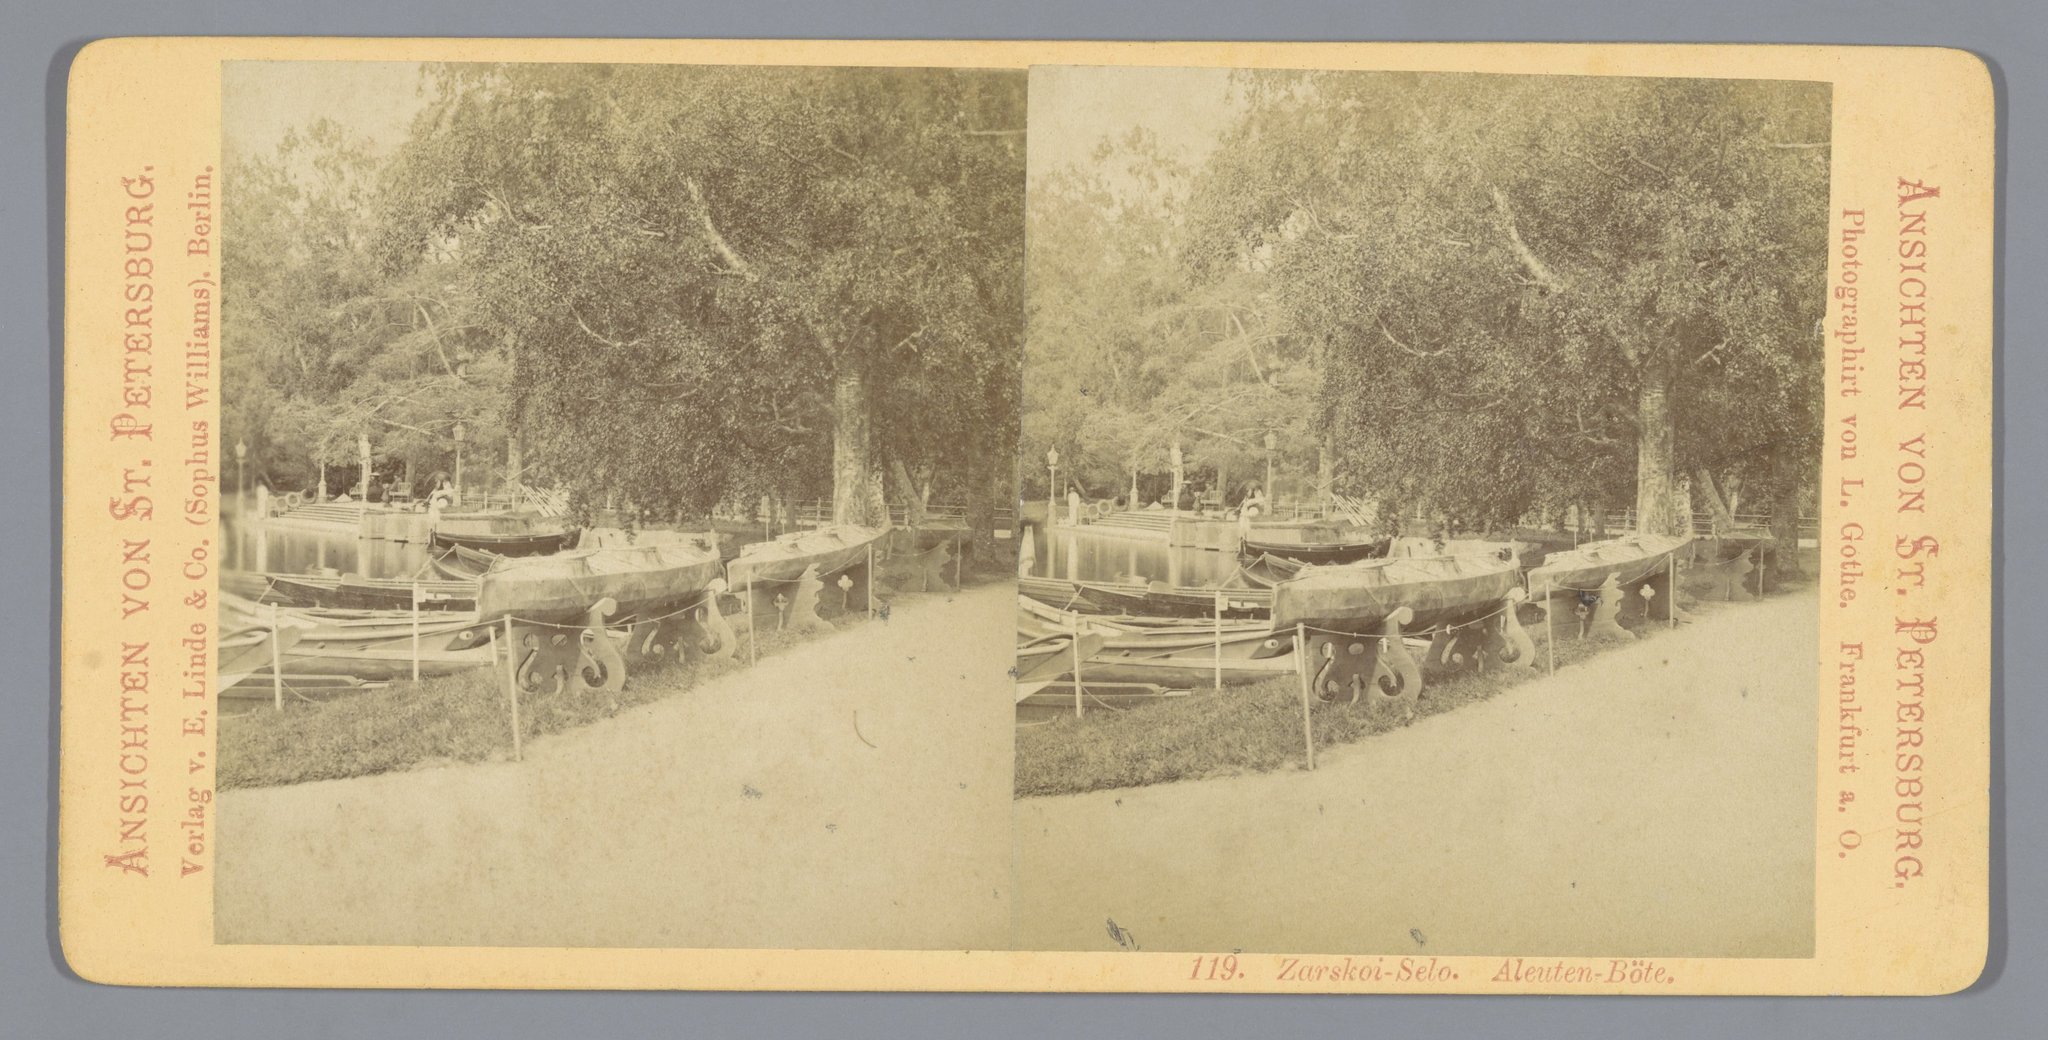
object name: stereograph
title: Roeiboten in het water en op de kant in Tsarskoje Selo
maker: louis gothe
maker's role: fotograaf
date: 1850-1880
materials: cardboard, photographic support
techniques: albumen print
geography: pushkin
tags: rowing-boat, canoe, etc.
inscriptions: inscription: ‘Ansichten von St. Petersburg.’, number: ‘119.’